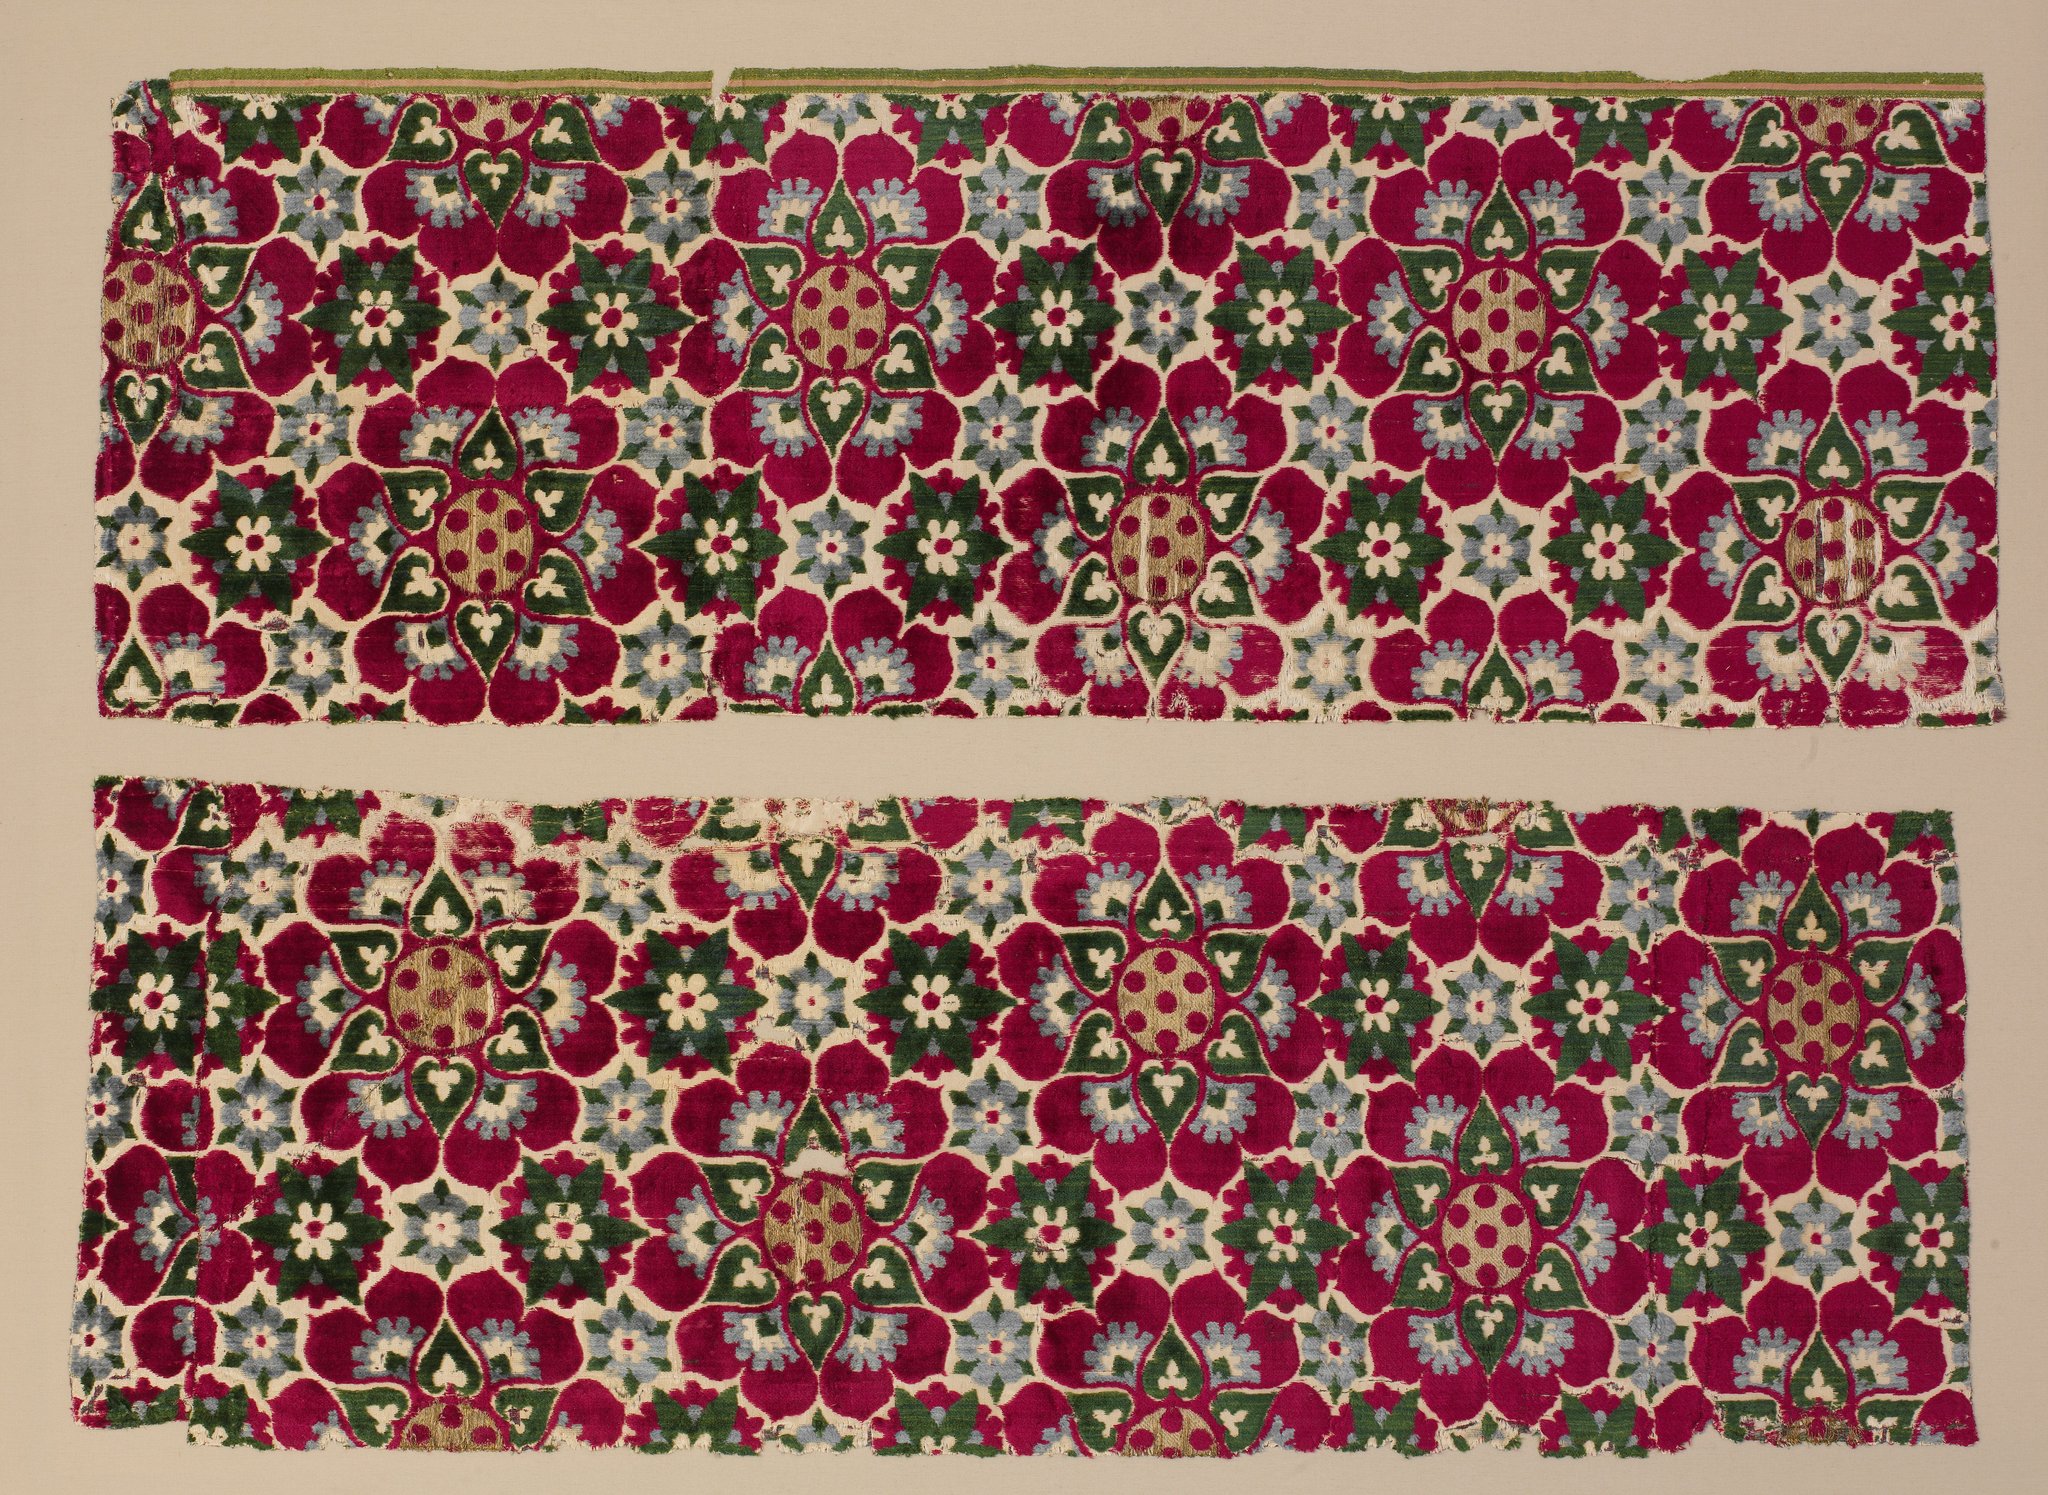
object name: fragment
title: Polychrome velvet with a variation on a Medici emblem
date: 1467-1500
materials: metal thread, silk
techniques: weave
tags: flowers